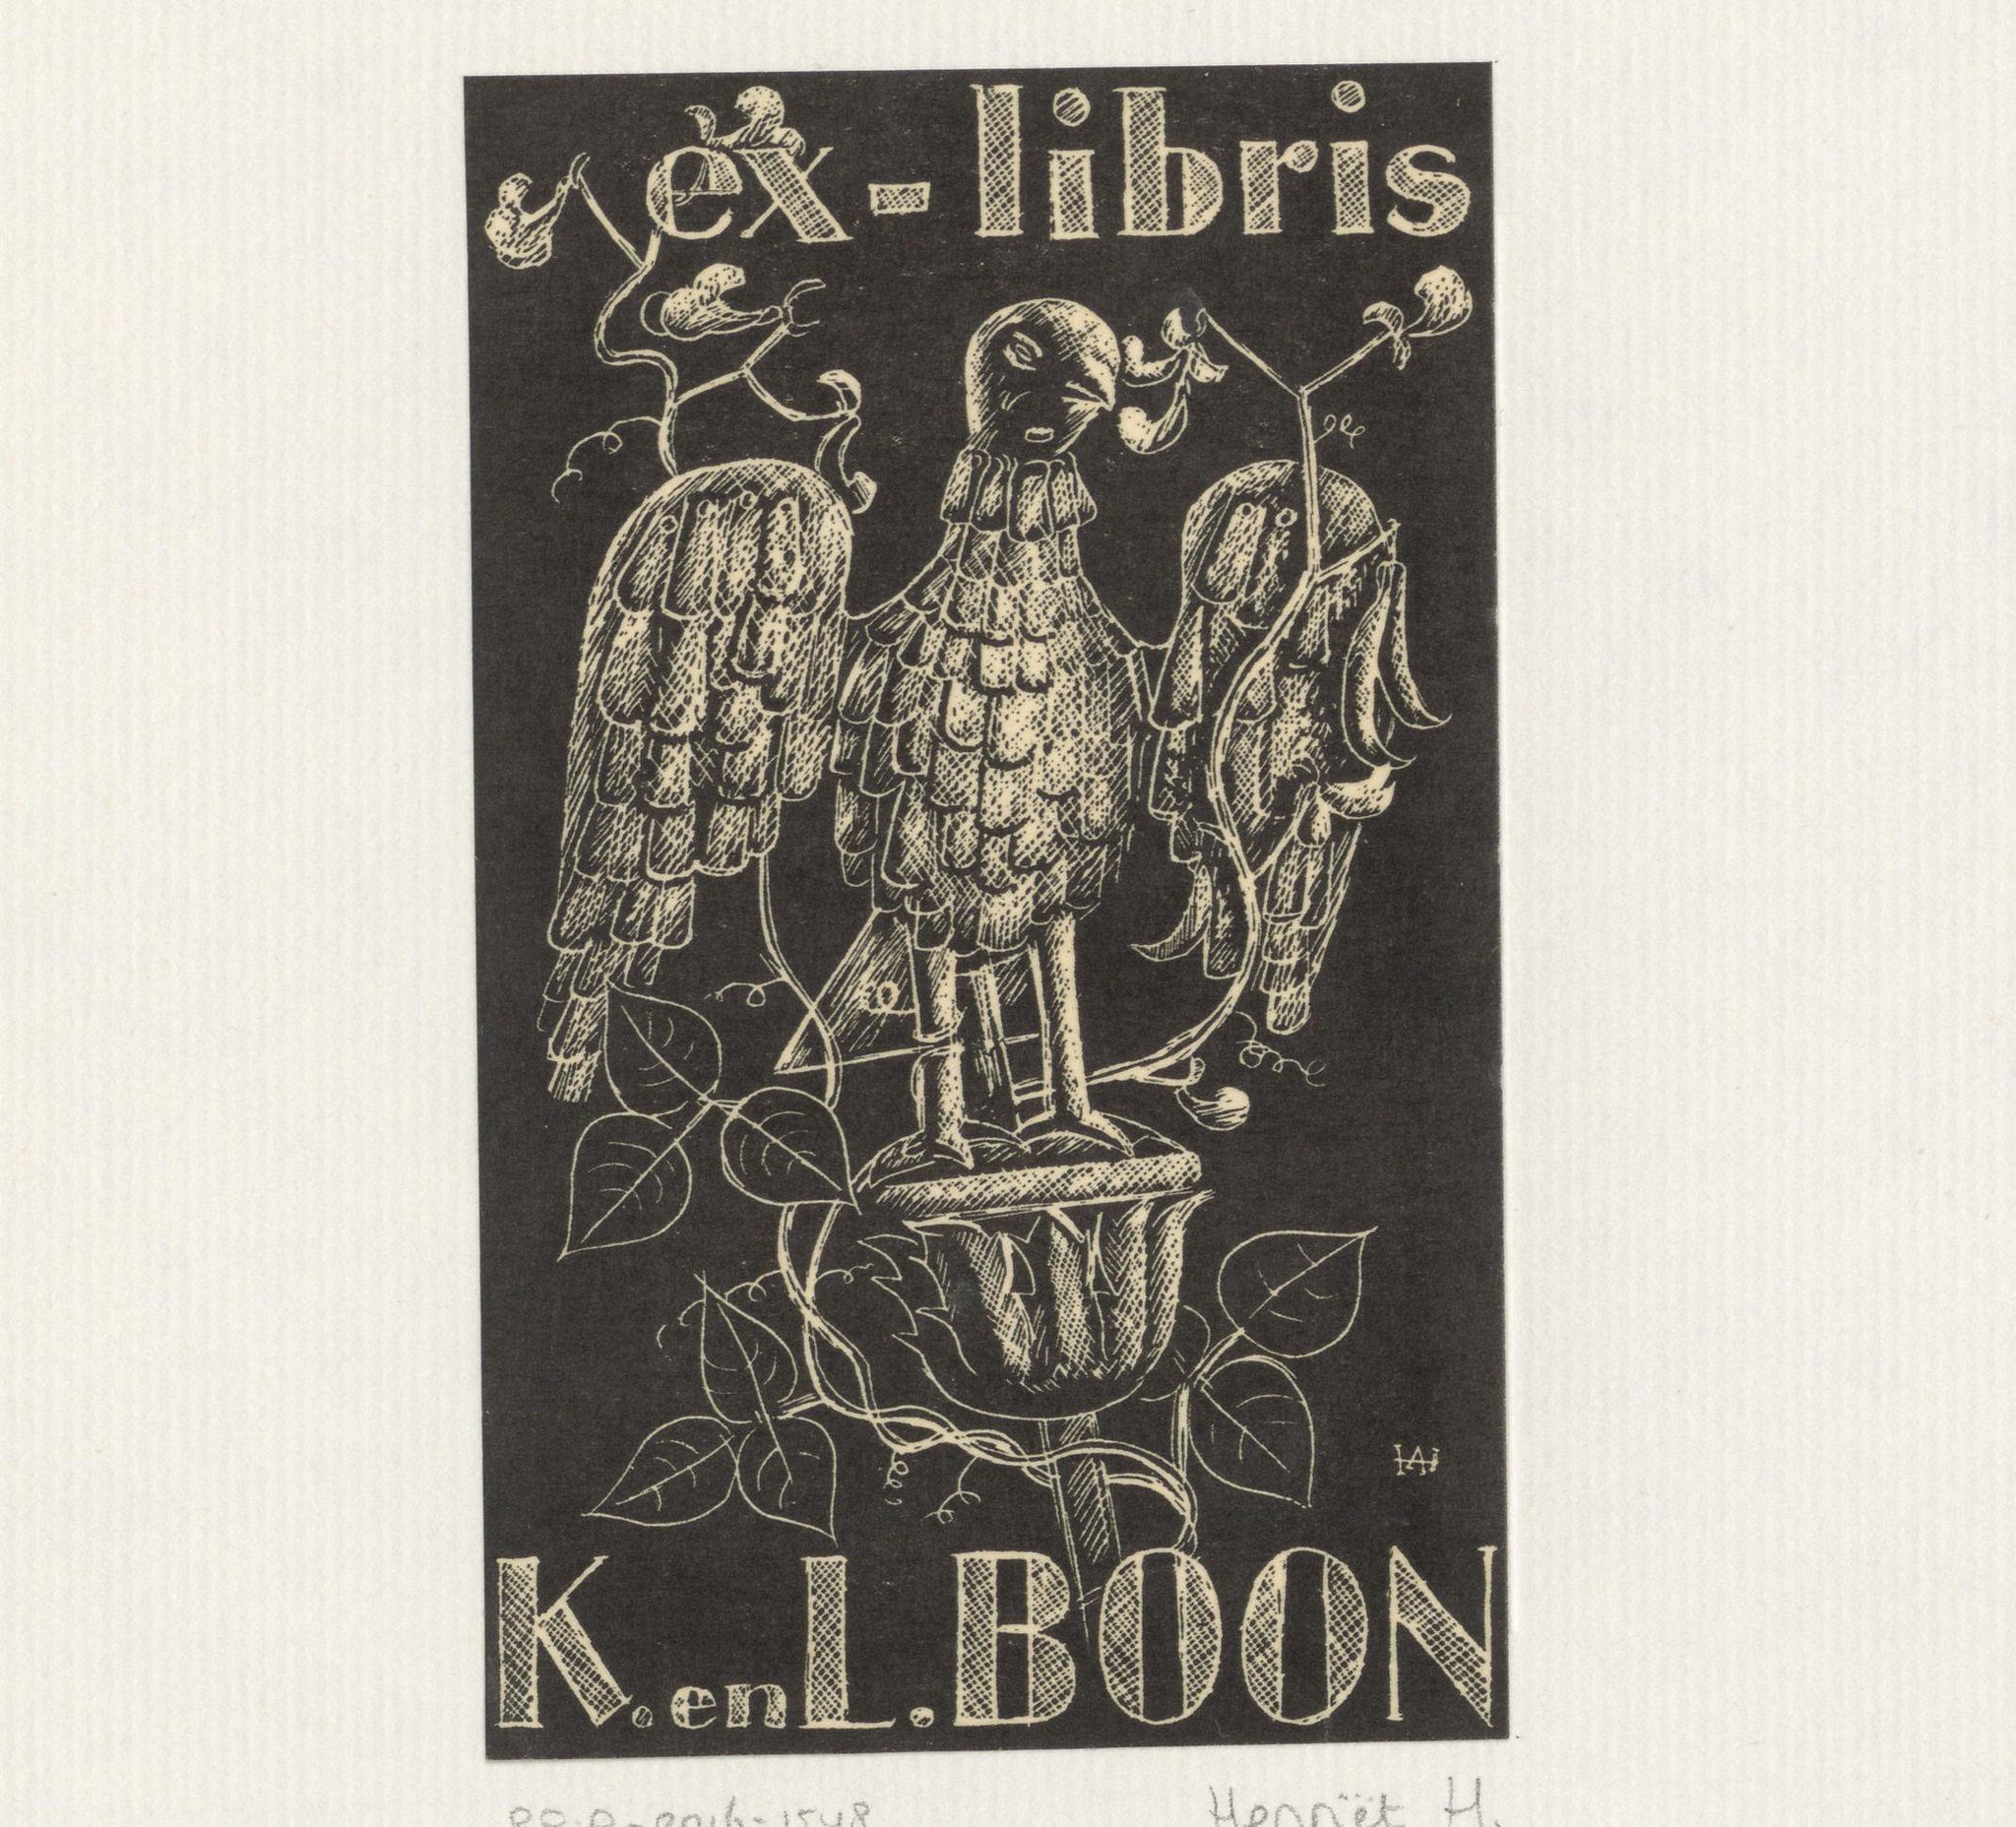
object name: bookplate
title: Ex libris van K. en L. Boon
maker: henk henriët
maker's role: draughtsman, print maker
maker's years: 1903-1945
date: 1913-1945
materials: paper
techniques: engraving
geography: netherlands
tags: birds